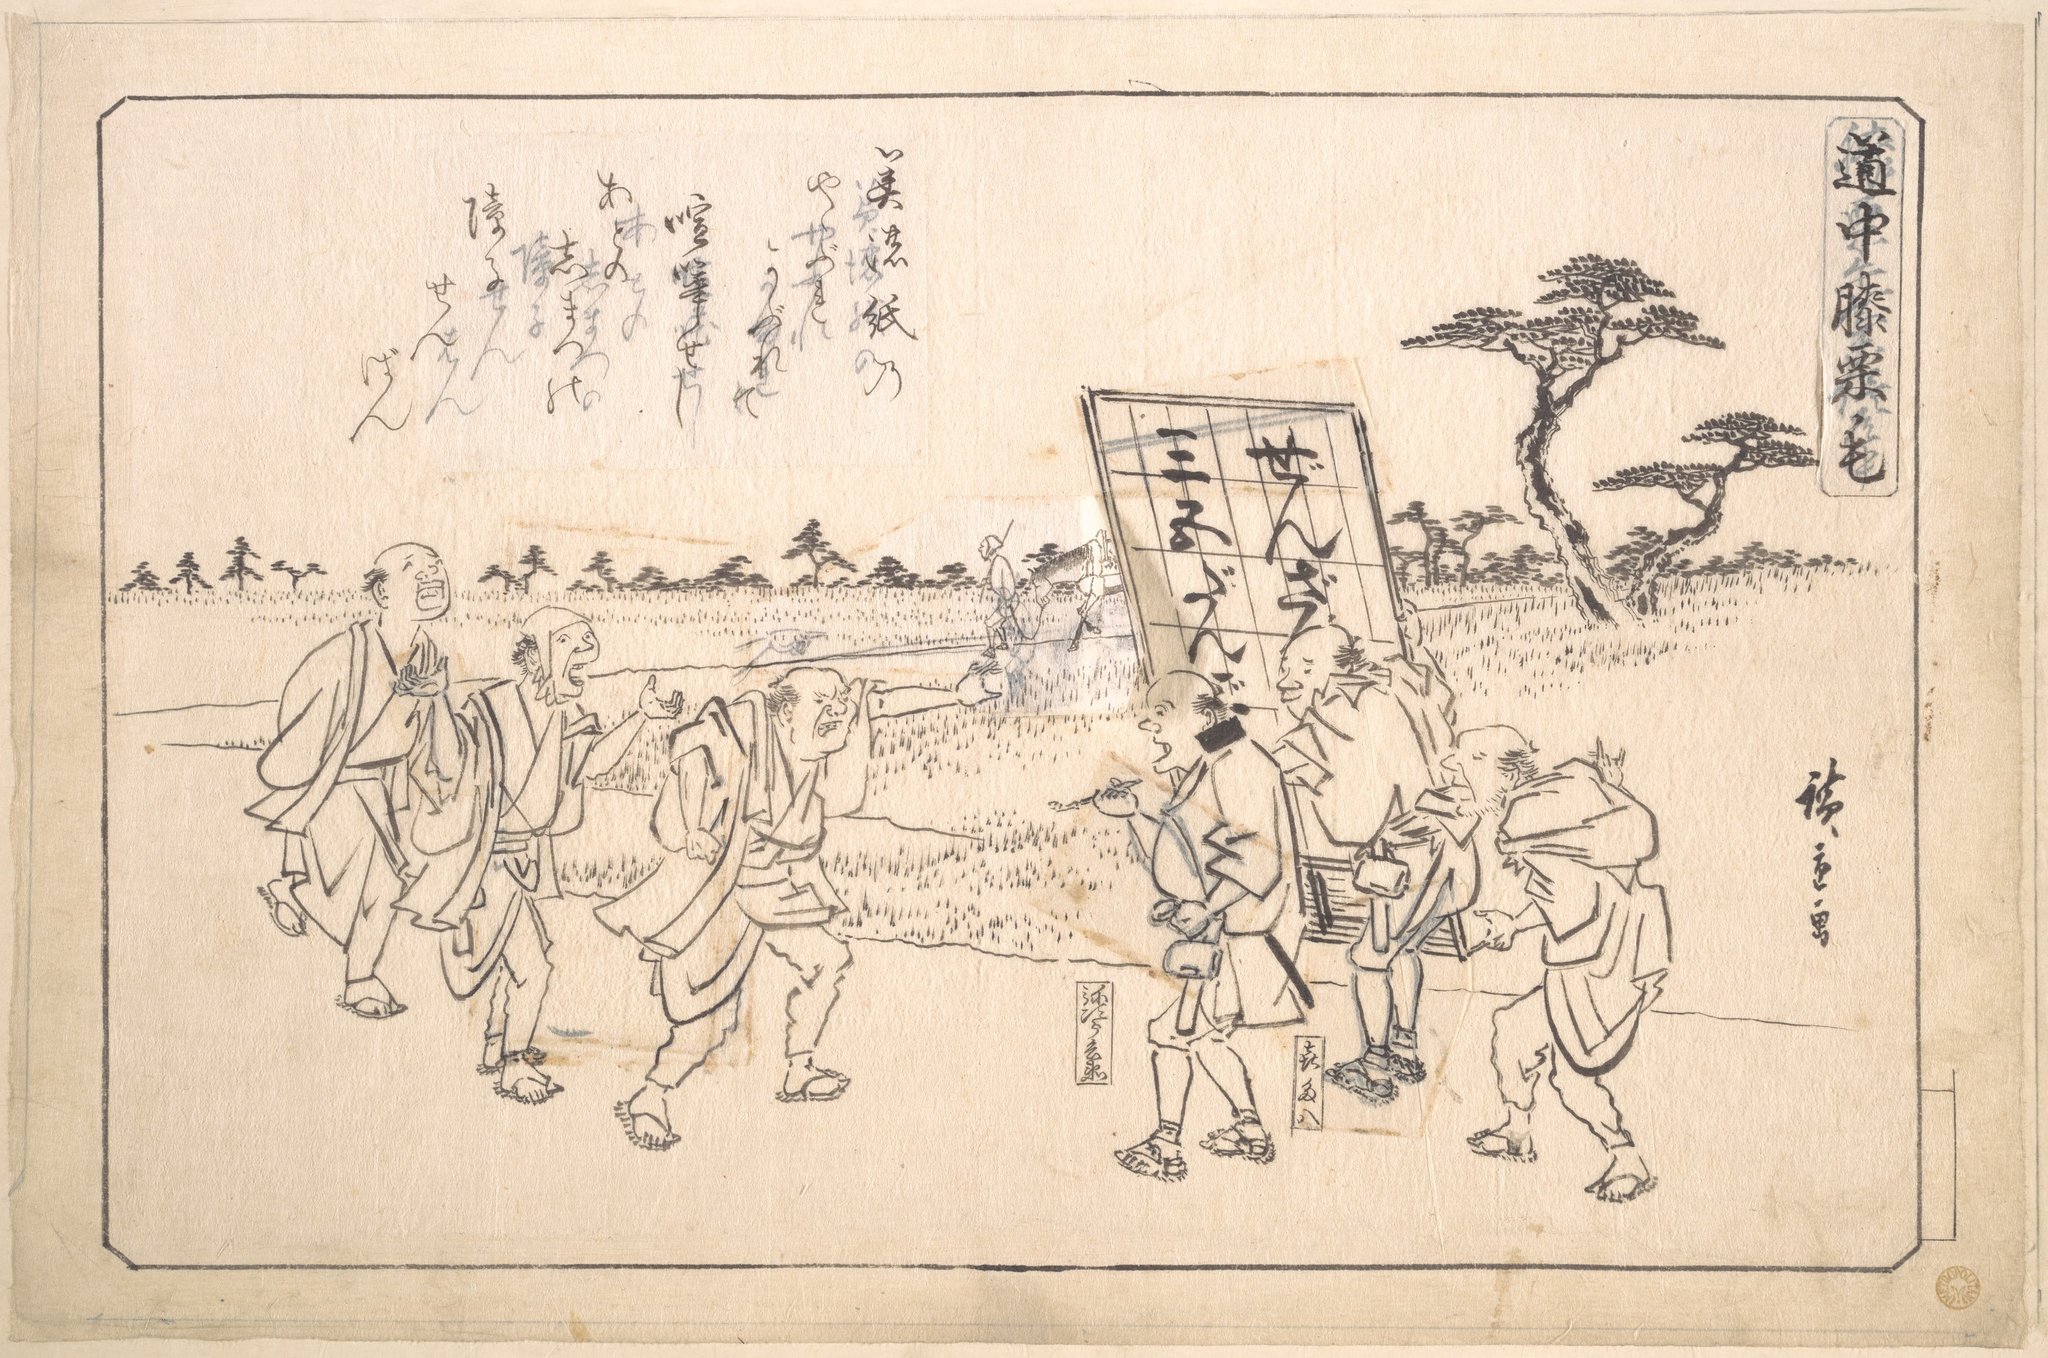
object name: woodblock print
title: The Practical Jokers Yajirobei and Kitahachi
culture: japanese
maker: utagawa hiroshige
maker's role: artist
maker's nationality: japanese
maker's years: 1797-1858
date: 1840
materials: ink, paper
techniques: woodblock print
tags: men,trees